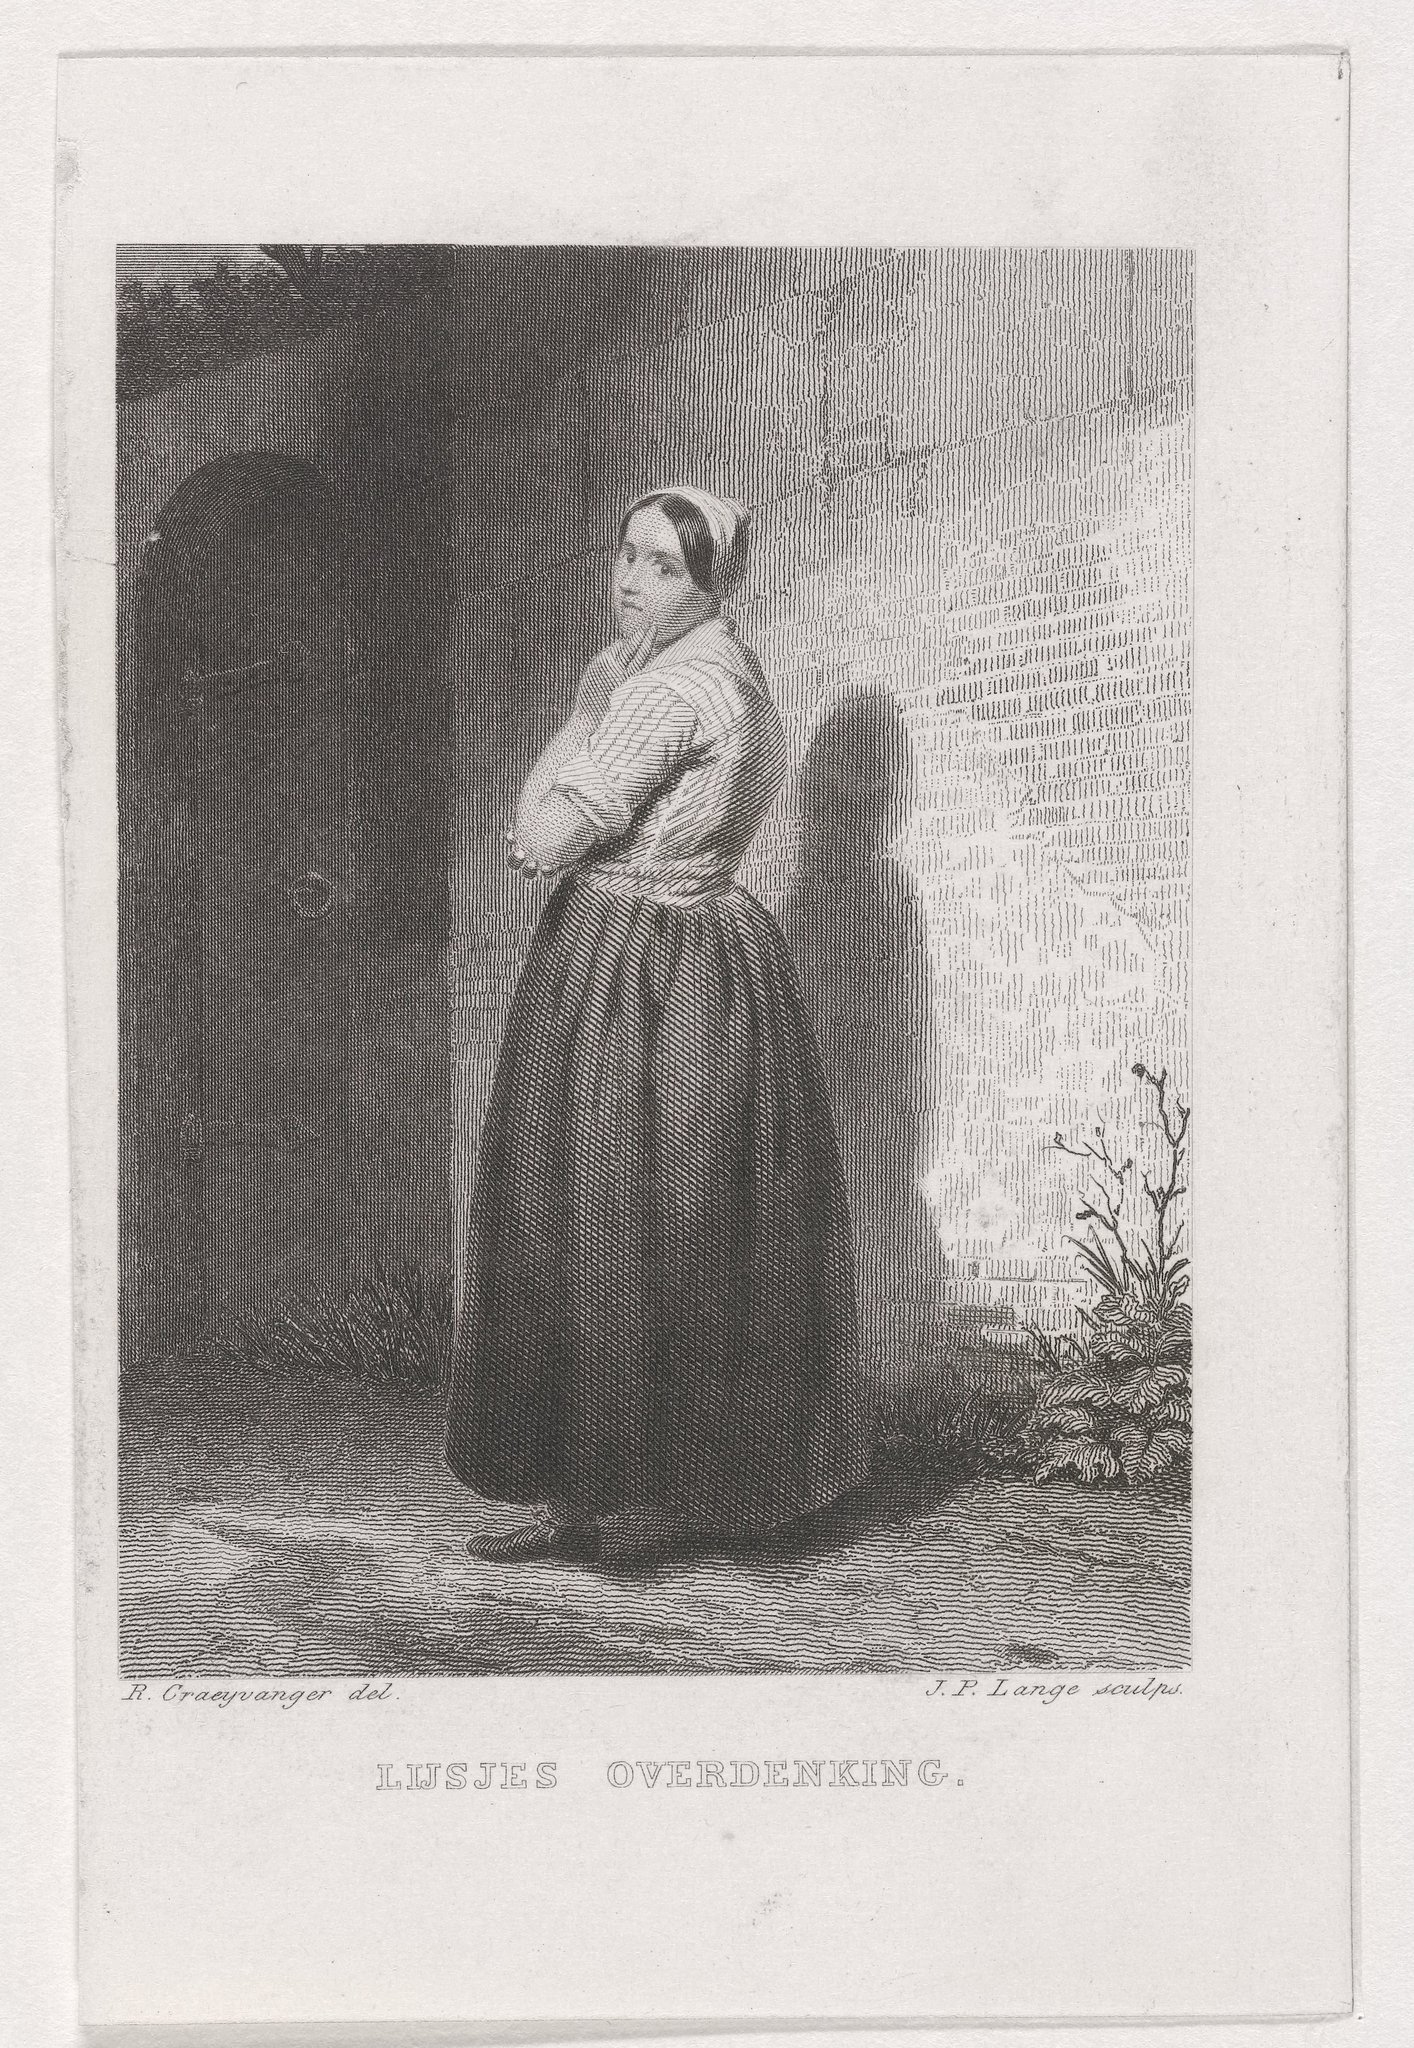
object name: print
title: Staande vrouw bij een buitenmuur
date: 1849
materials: paper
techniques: engraving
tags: gate, entrance, village-walls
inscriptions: collector's mark: Lugt 2228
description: Een vrouw, ten voeten uit en kijkend over haar schouder, staat bij een kleine poort in een buitenmuur.